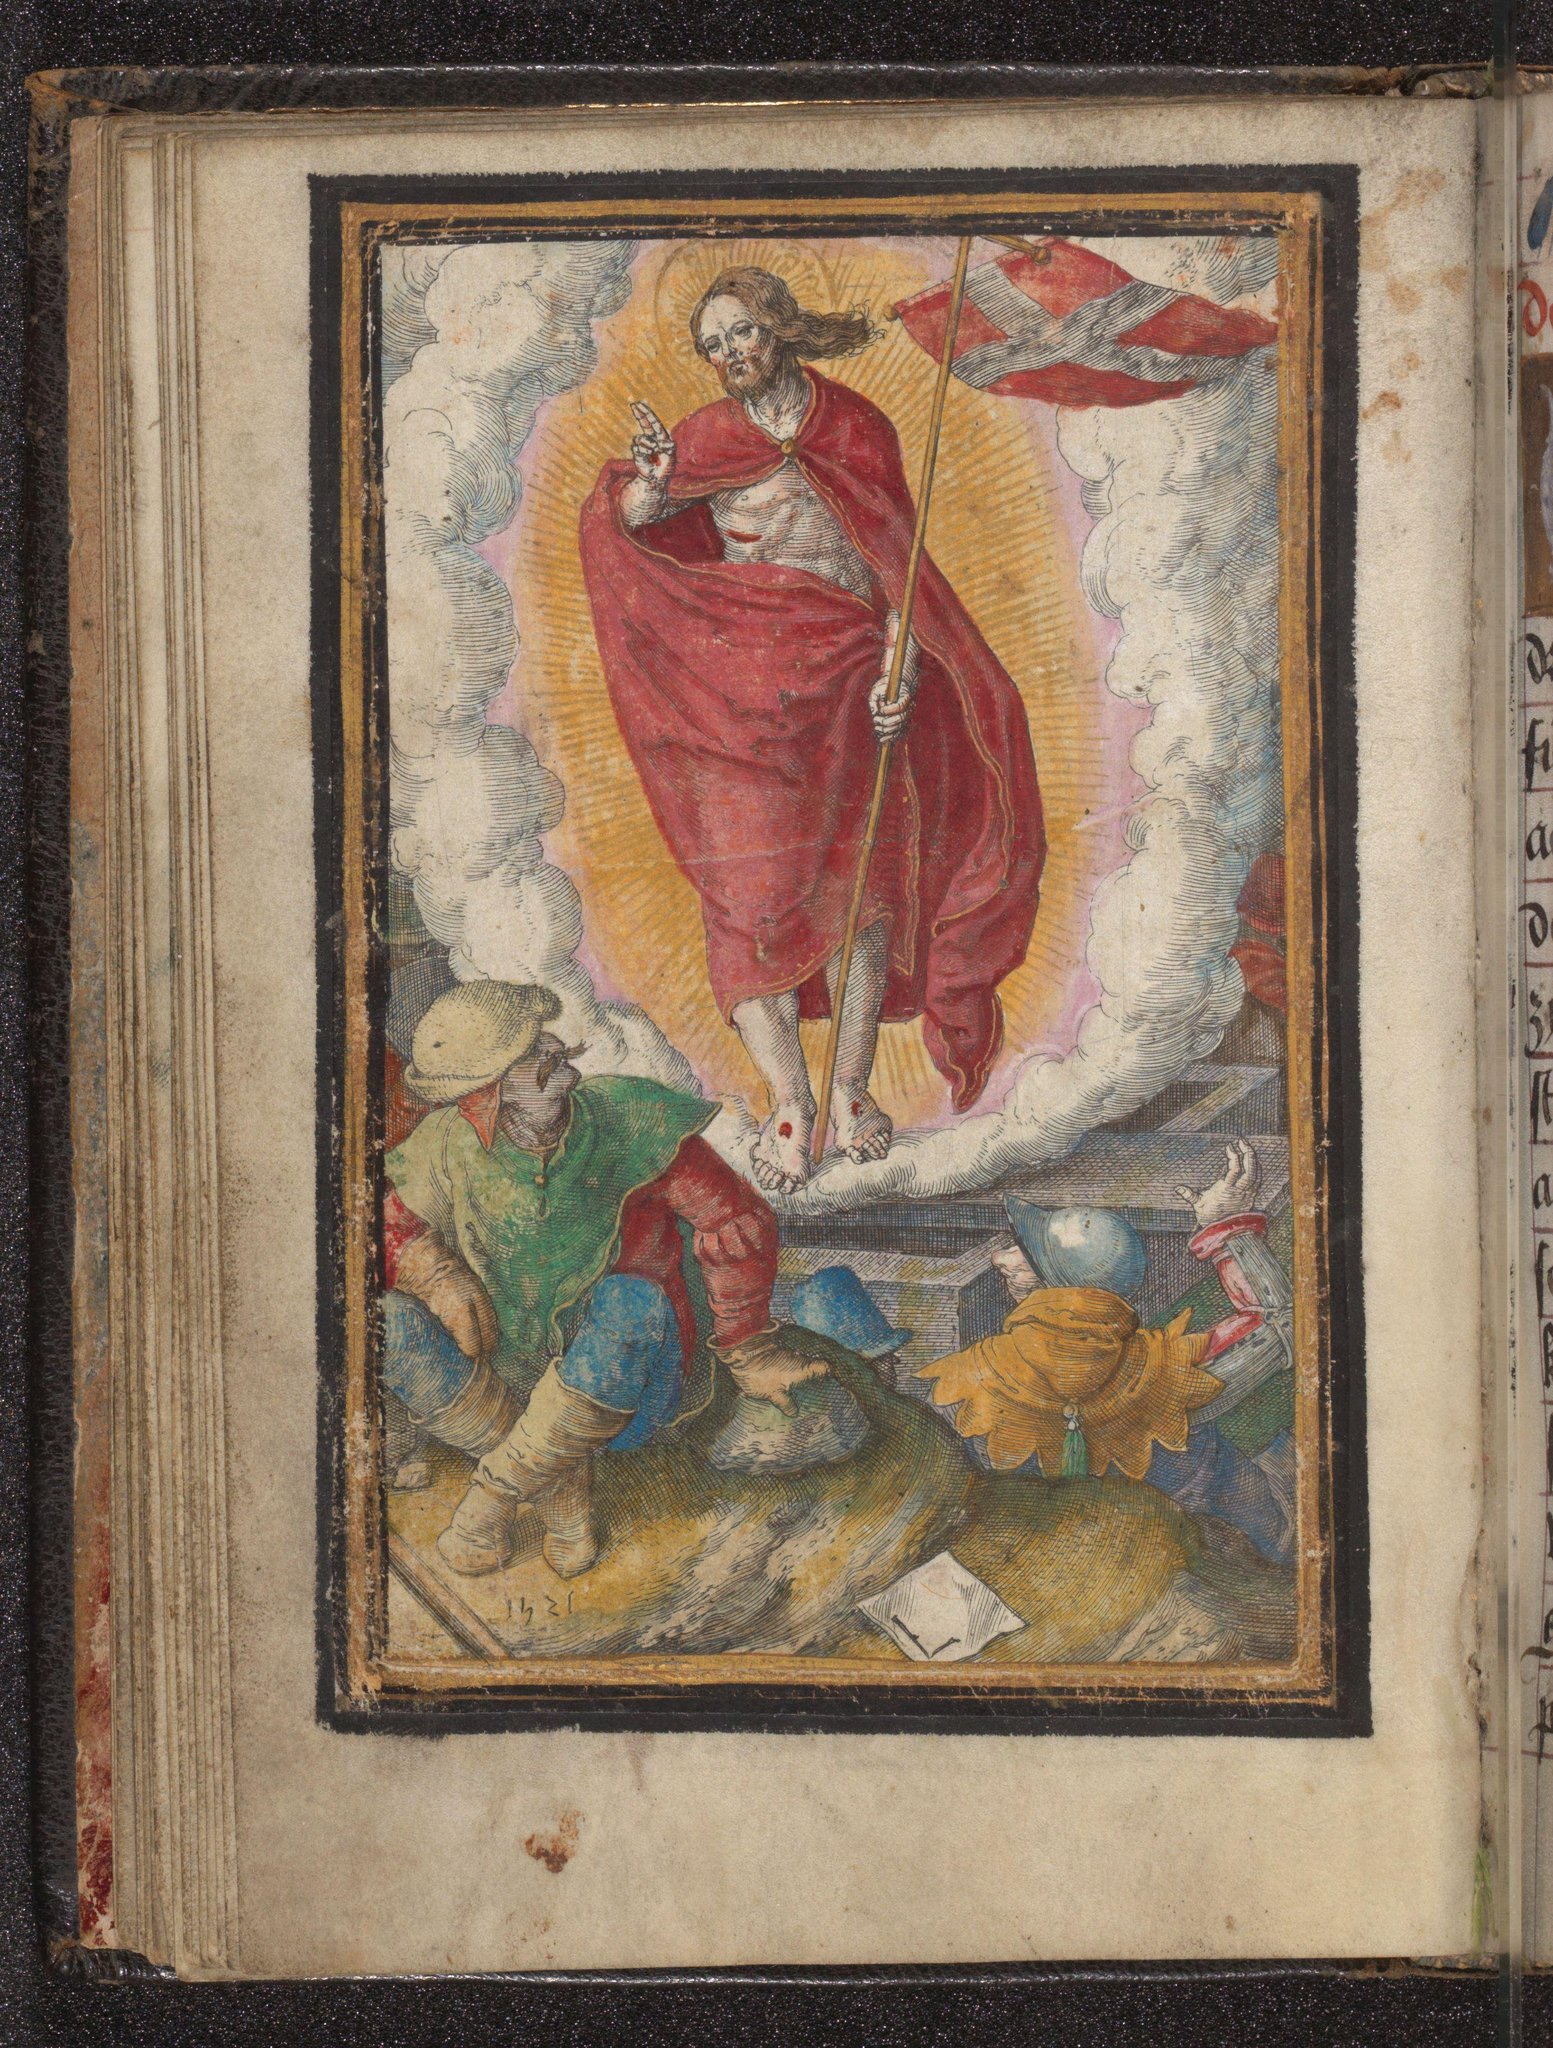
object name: print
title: Opstanding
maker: lucas van leyden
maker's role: draughtsman, painter, print maker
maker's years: 1494-1533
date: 1521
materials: paper, parchment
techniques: engraving, hand coloring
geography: leiden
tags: christ, usually holding a banner, arises from the grave; often combined with sleeping and/or frightened soldiers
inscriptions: date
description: Christus verschijnt met de banier van de Opstanding in de hand boven de geopende sarcofaag. Rond het graf geschrokken soldaten. Deze prent maakt deel uit van een handgeschreven gebedenboek.